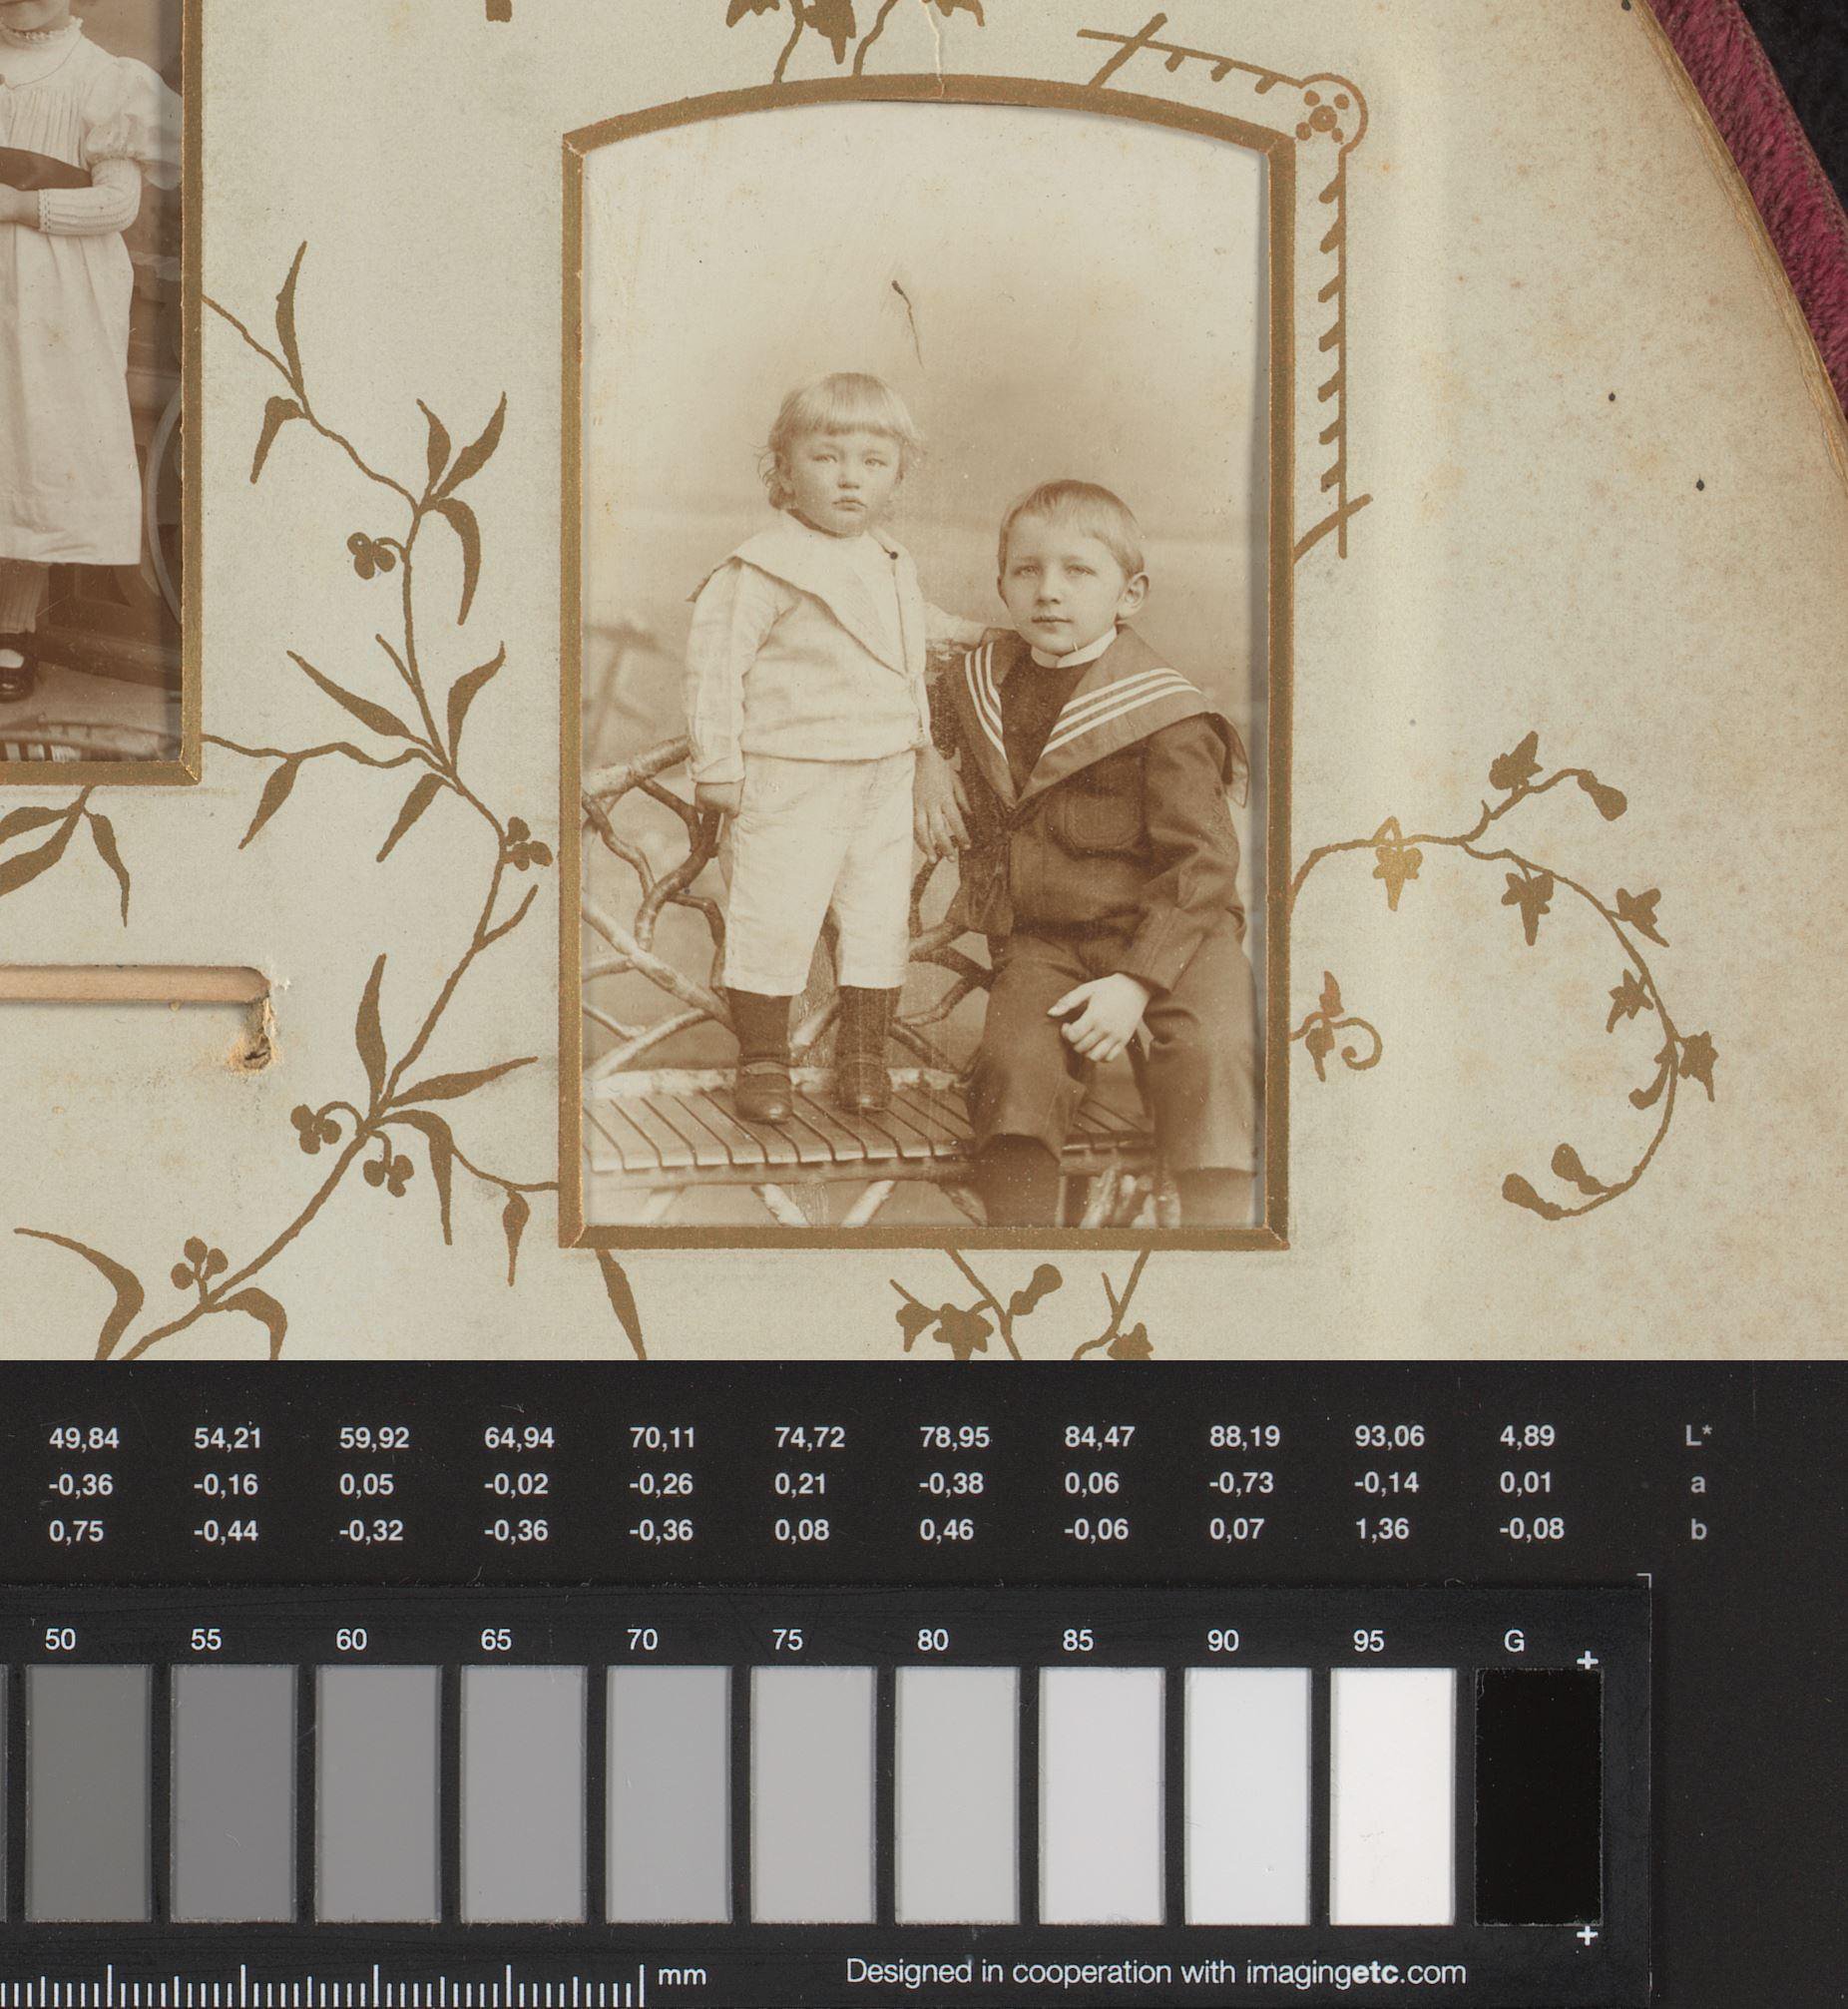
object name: photograph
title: Portret van twee kinderen in matrozenpakken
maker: max kretzschmer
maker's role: fotograaf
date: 1860-1900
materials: cardboard, photographic support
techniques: collodion silver print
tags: child, historical persons, tot, toddler ~ the ages of man, trade games, imitative games, imitating adults